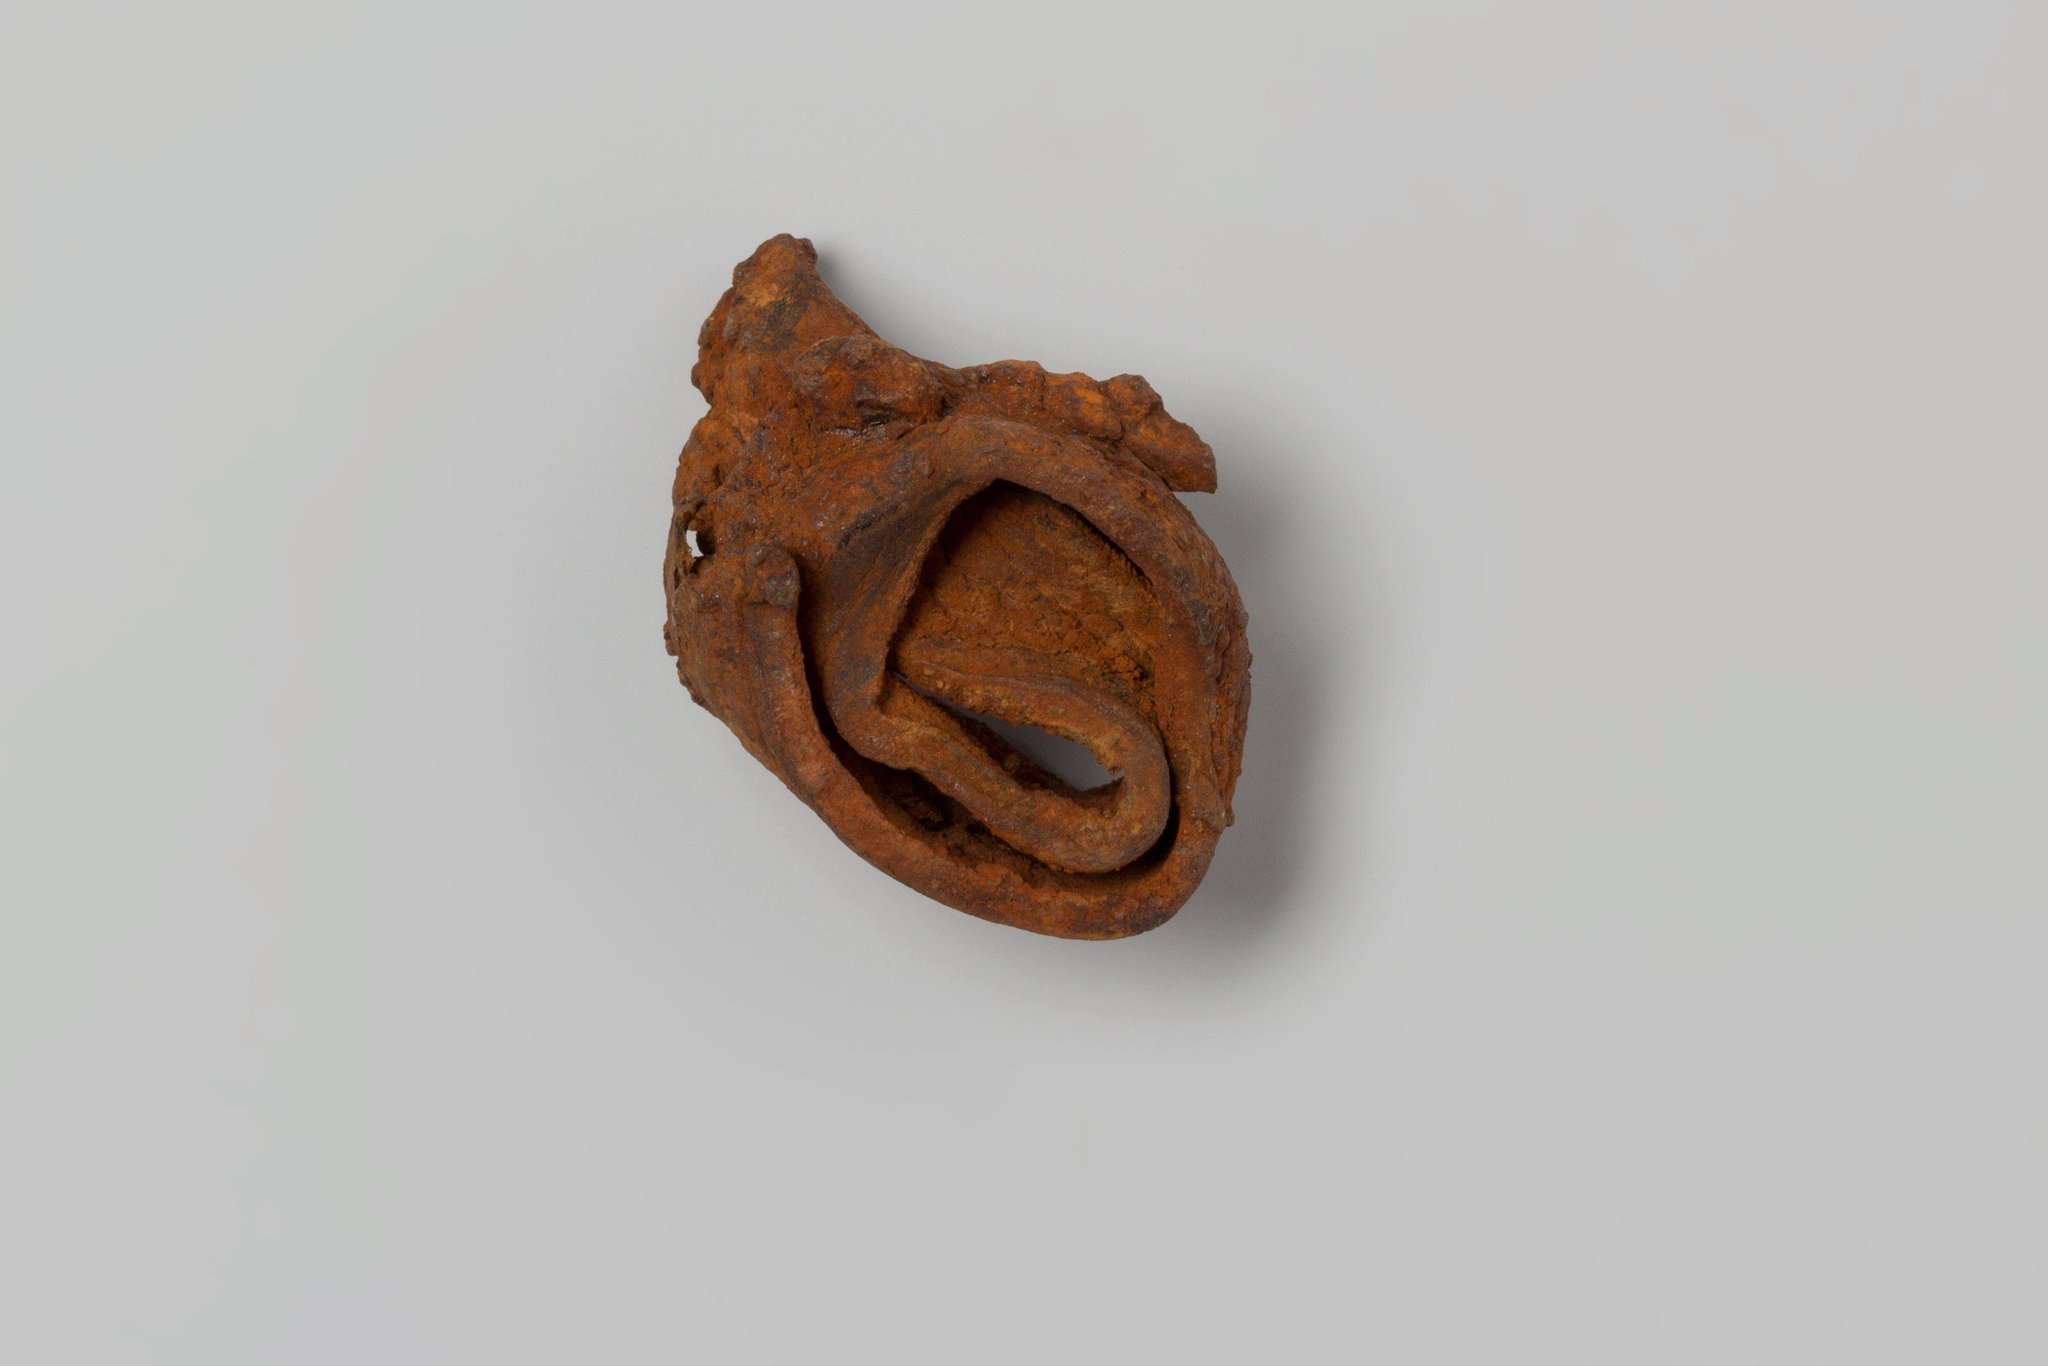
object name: knife with sheath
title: Fragment van een schede uit het wrak van de Oost-Indiëvaarder Hollandia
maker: Anonymous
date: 1700-1743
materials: leather, wood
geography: netherlands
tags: verenigde oostindische compagnie, hollandia (schip)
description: Scabbard; fragm, sim. NG 1980-27H1832, with fragm of leather belt.